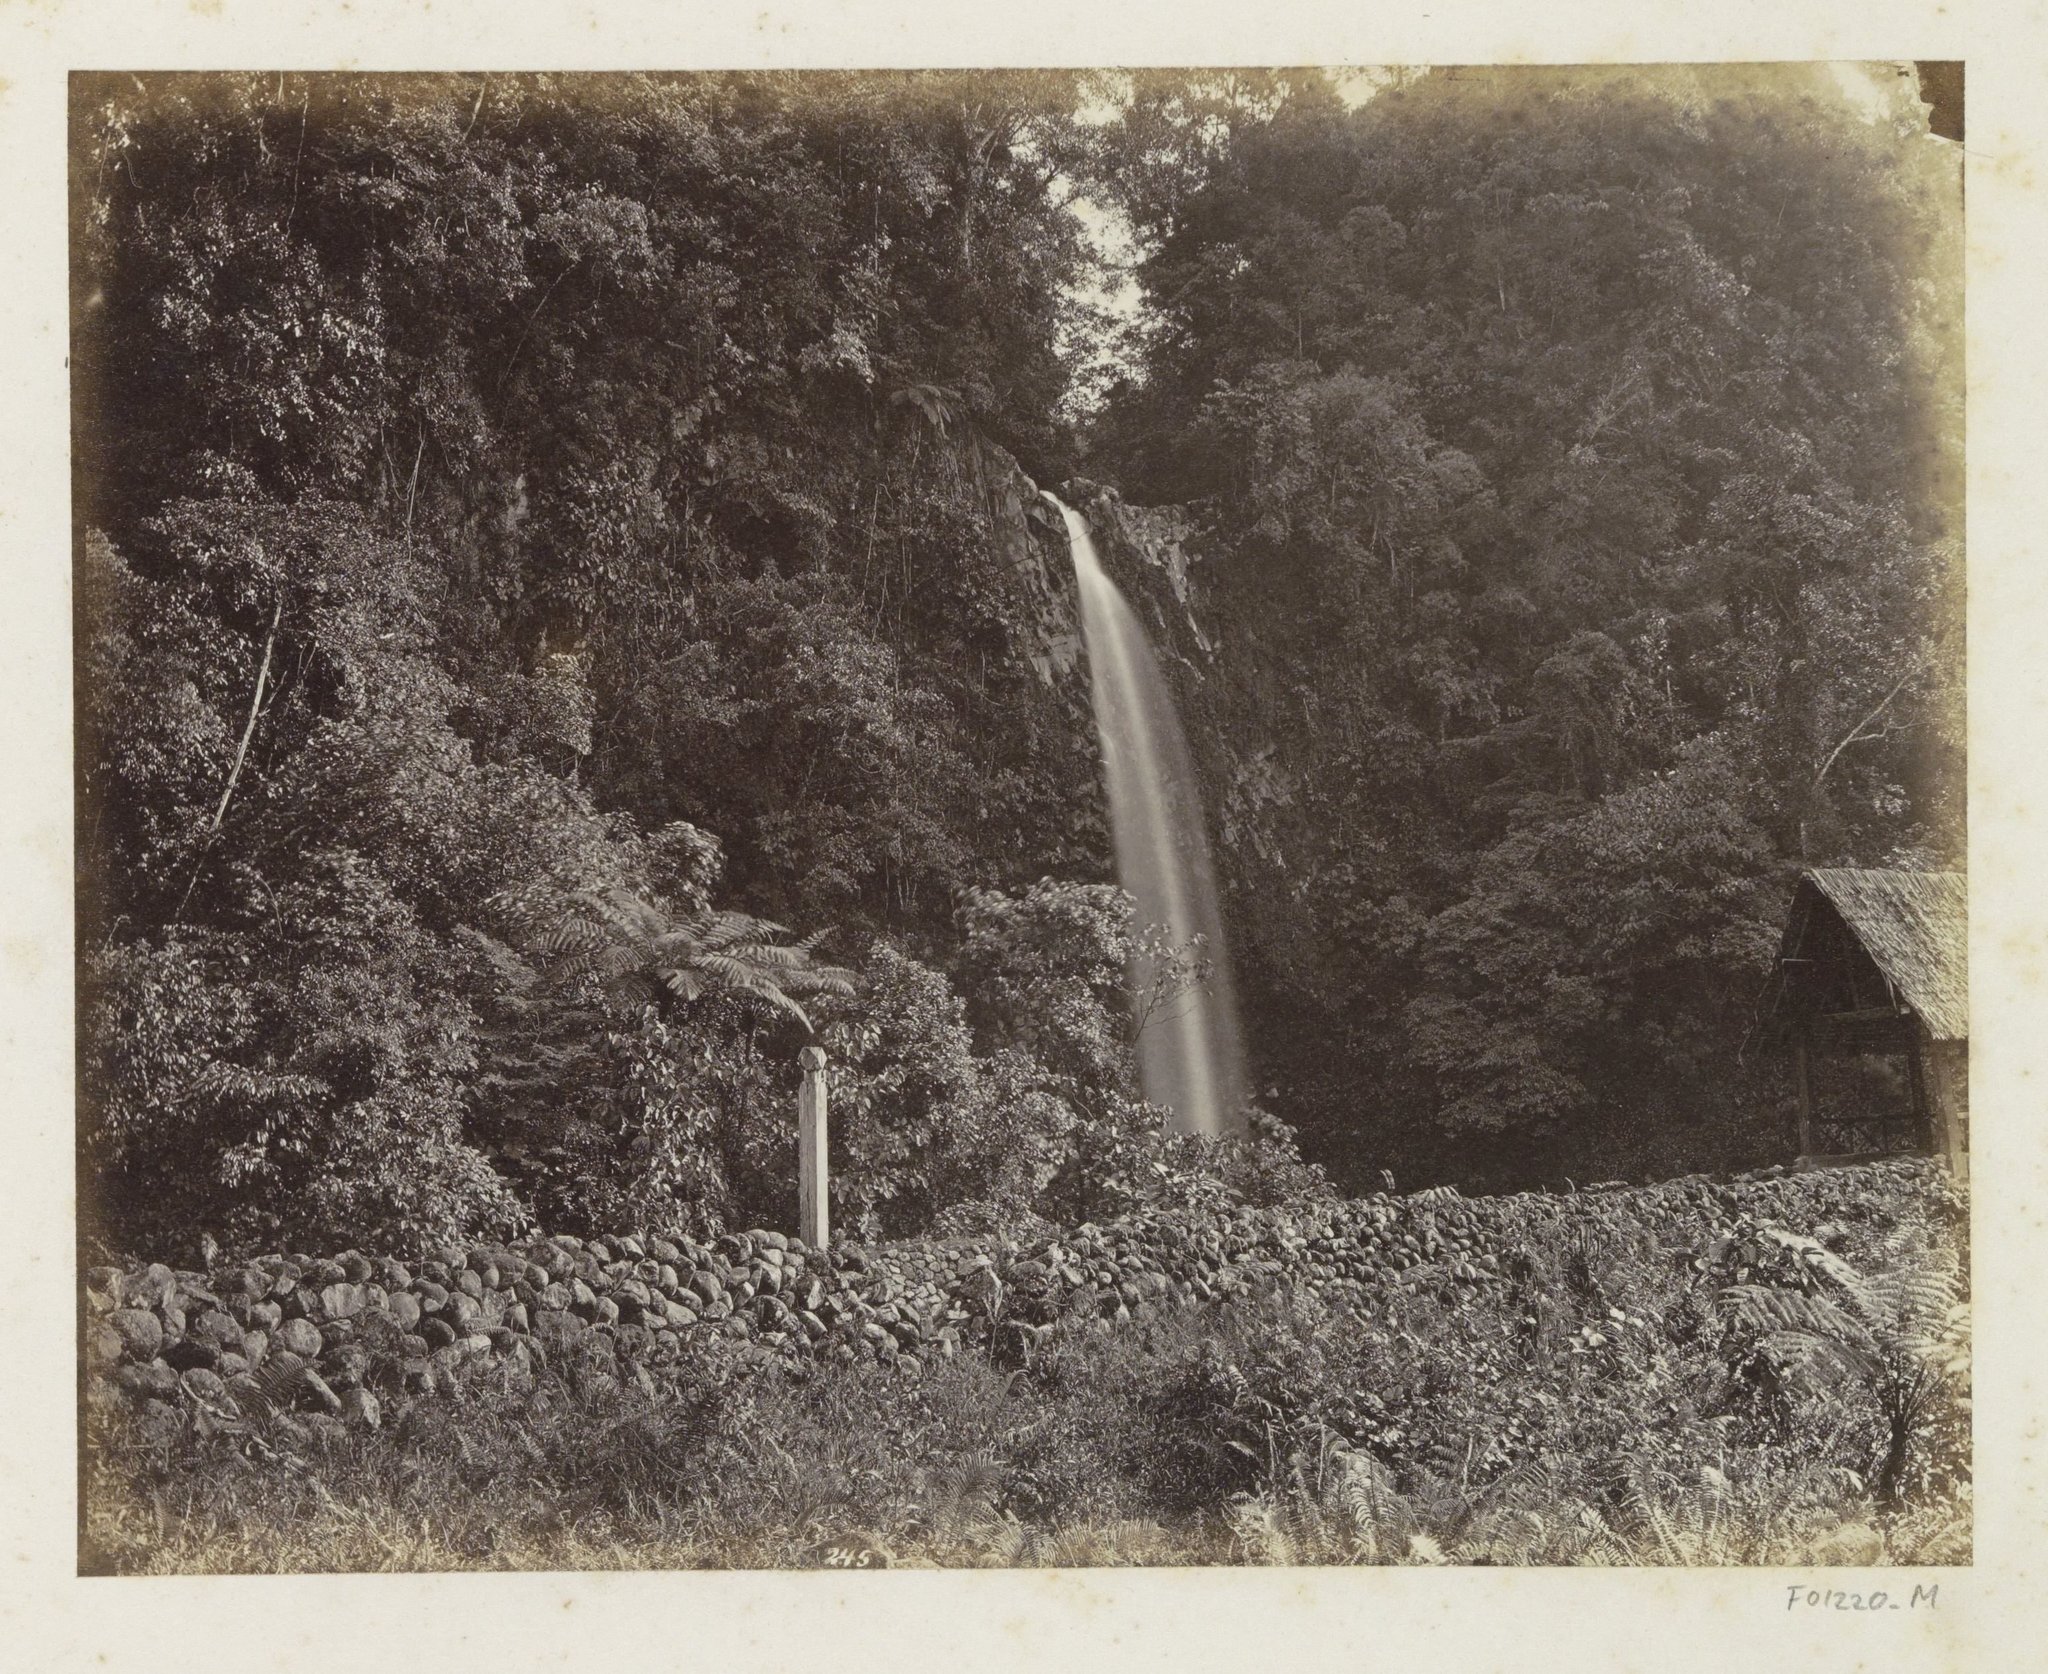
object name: photograph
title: Waterval bij een woning op Java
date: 1857-1870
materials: photographic support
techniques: albumen print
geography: java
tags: waterfall, java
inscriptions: number: ‘245’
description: Onderdeel van Fotoalbum met opnames van bezienswaardigheden op Java.